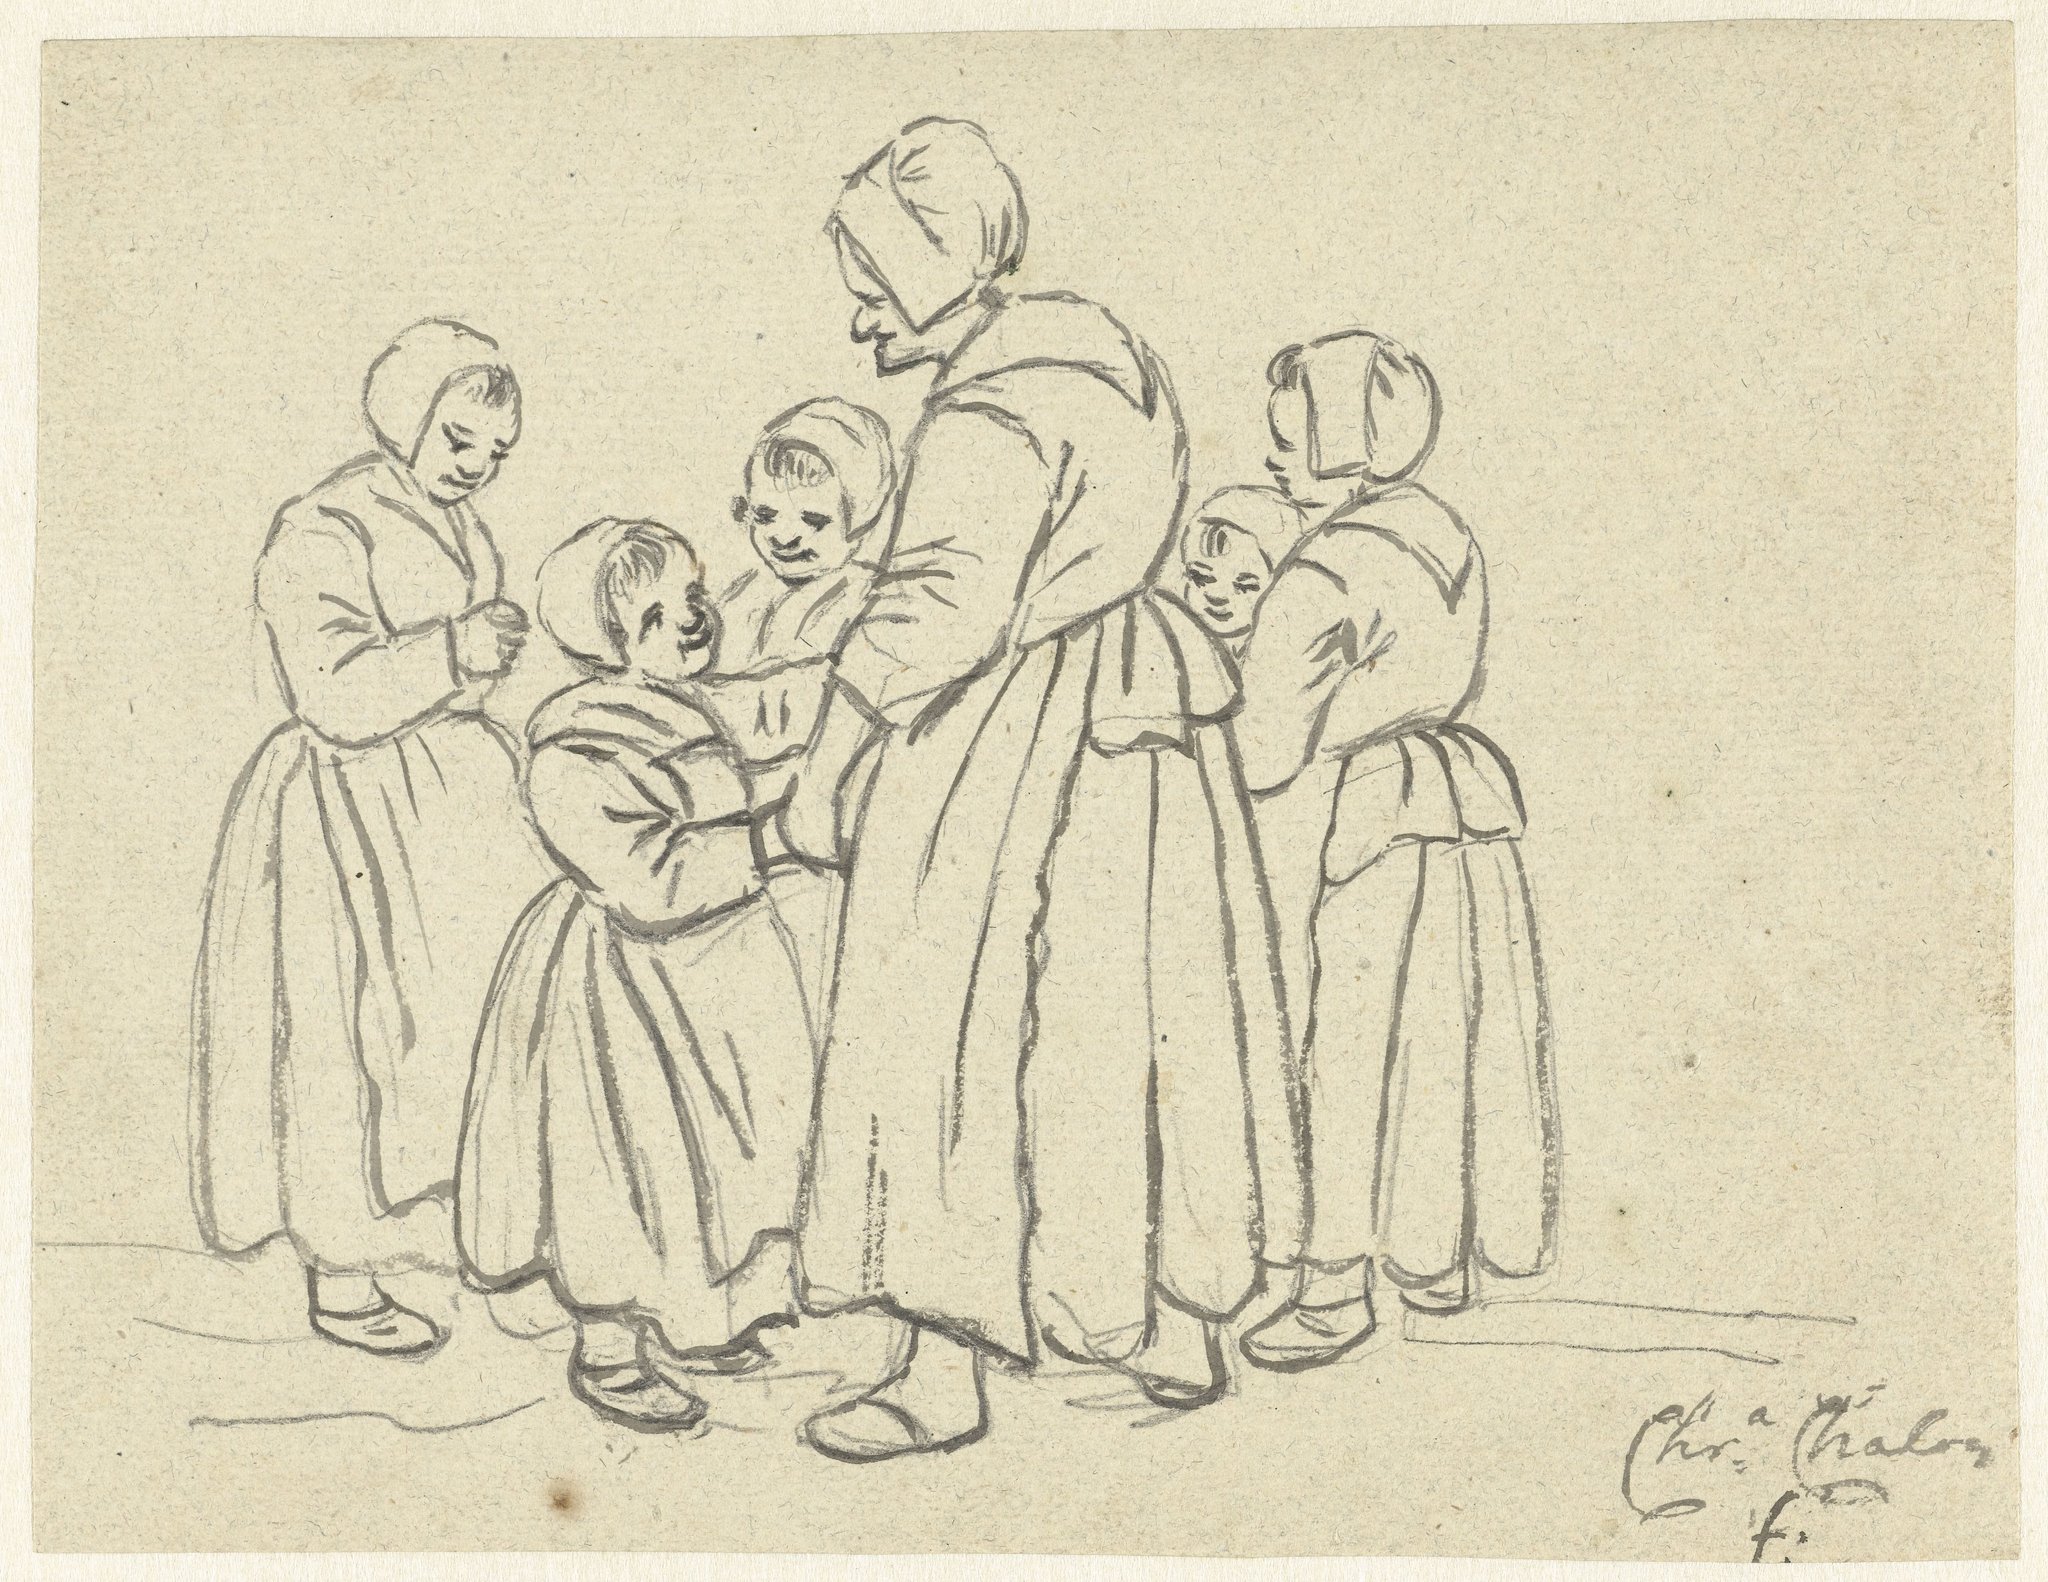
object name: drawing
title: Groep kinderen met een oude vrouw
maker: christina chalon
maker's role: draughtsman, print maker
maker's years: 1748-1808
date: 1758-1808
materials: ink, paper, pencil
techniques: pen